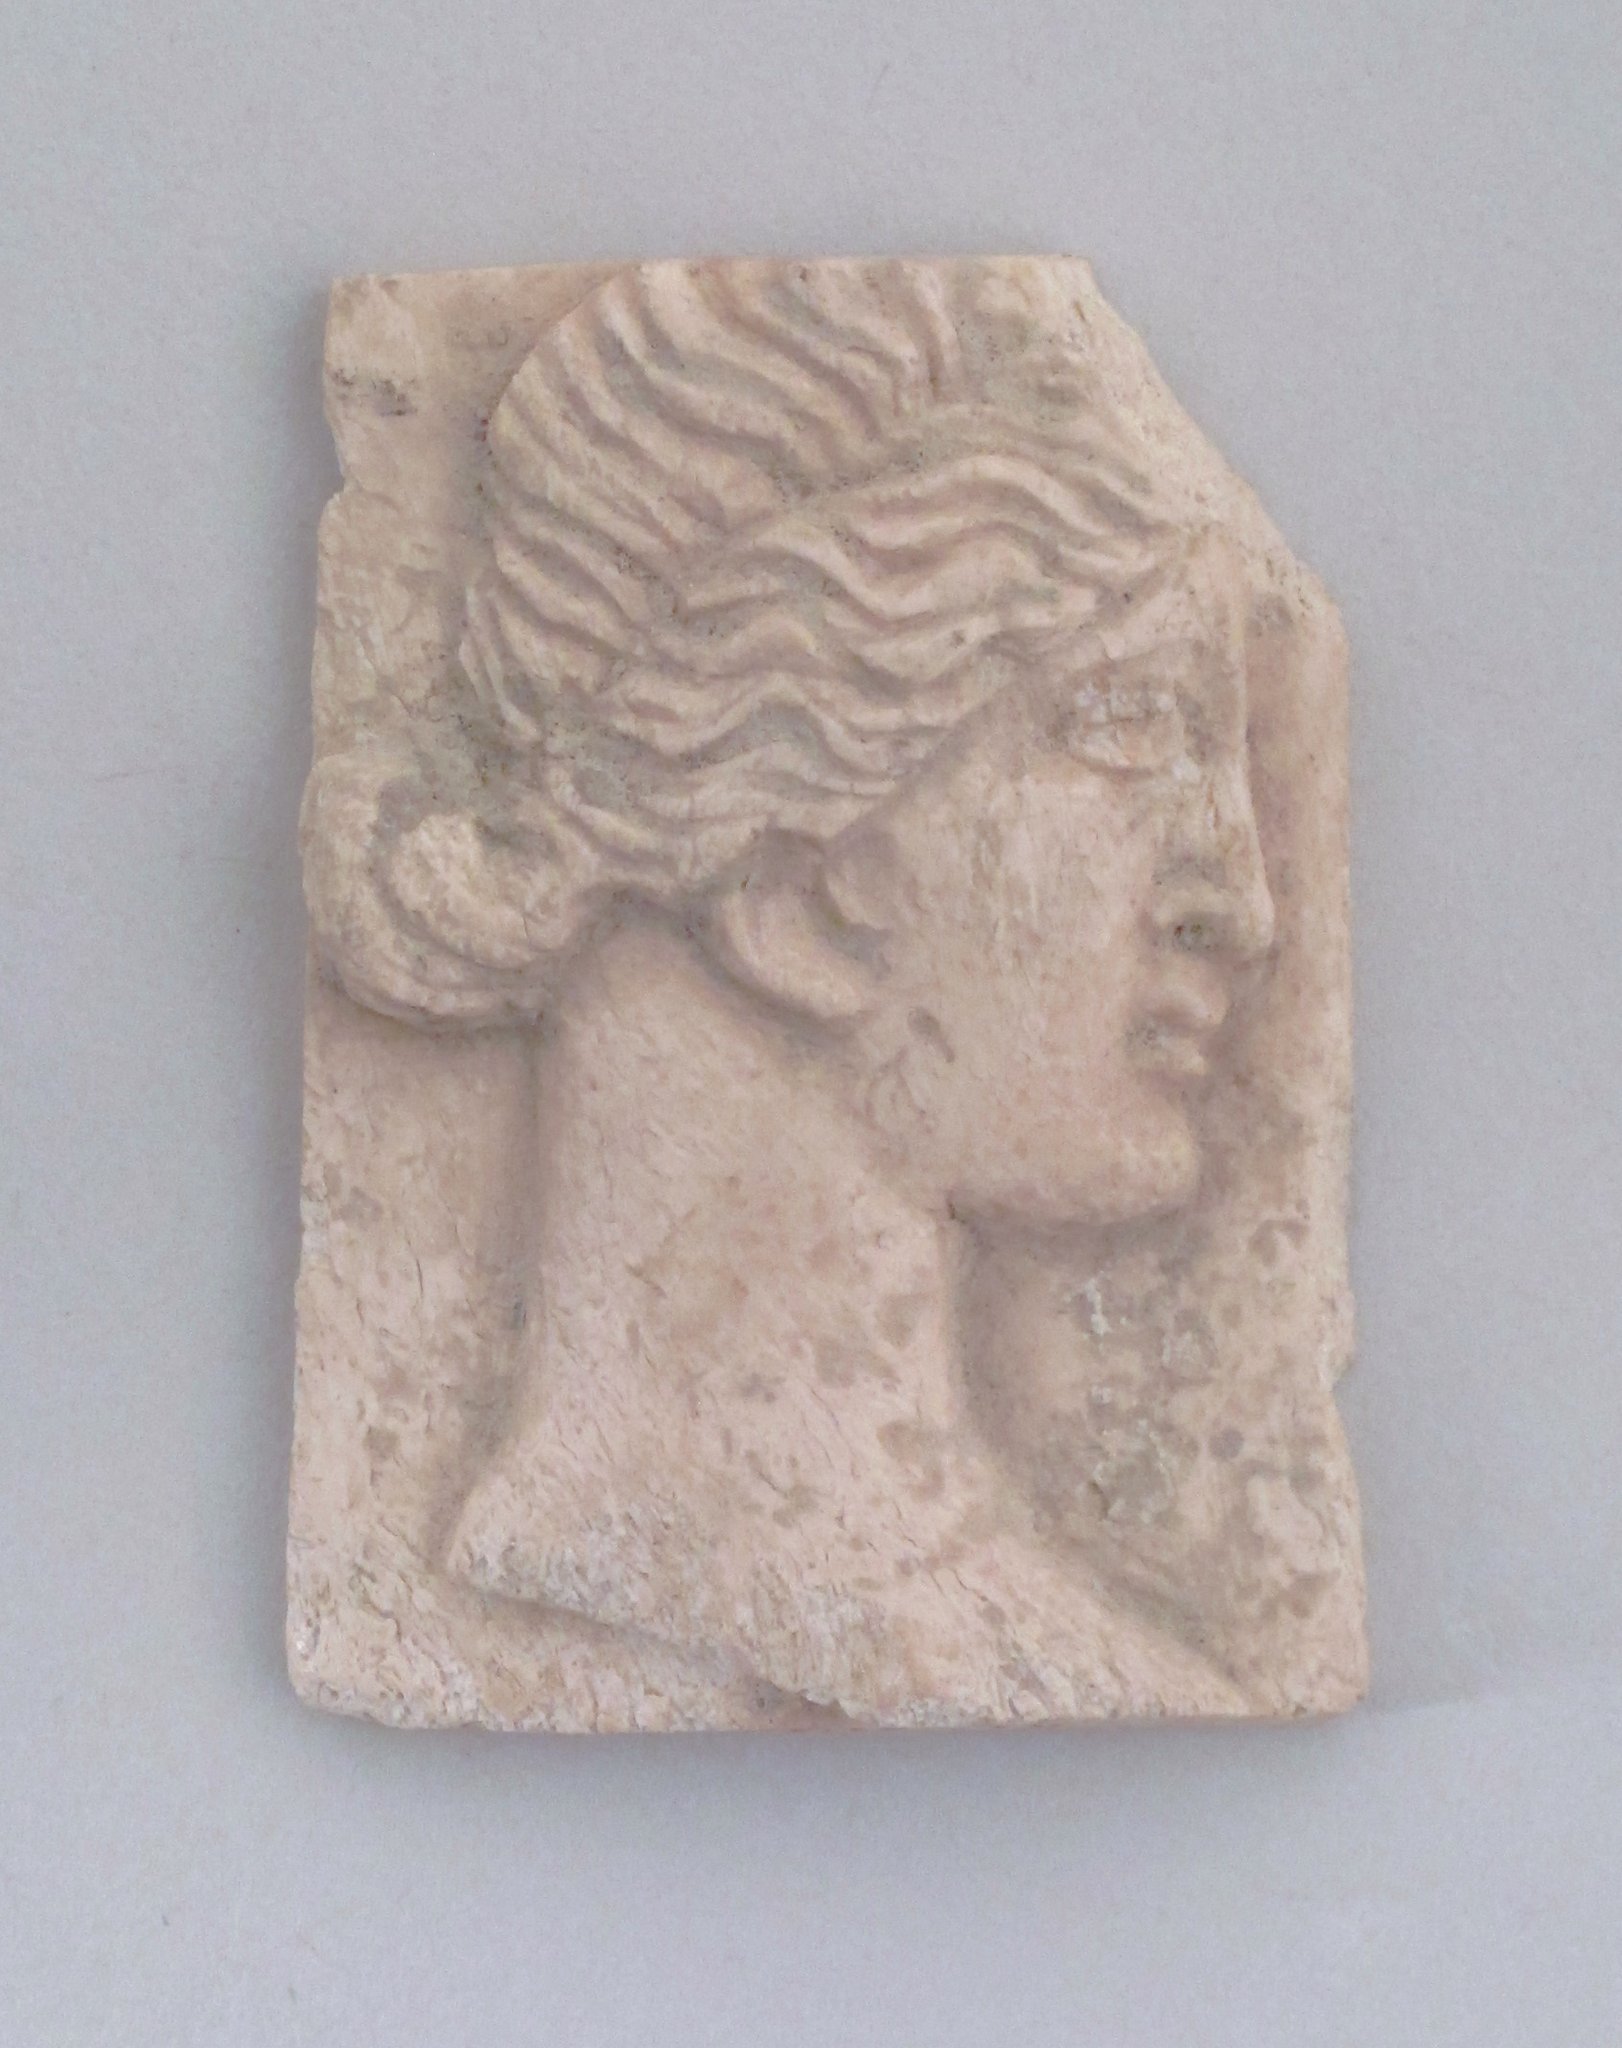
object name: relief of a head of woman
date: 7000 BCE-330 CE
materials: ivory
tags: heads,profiles,women